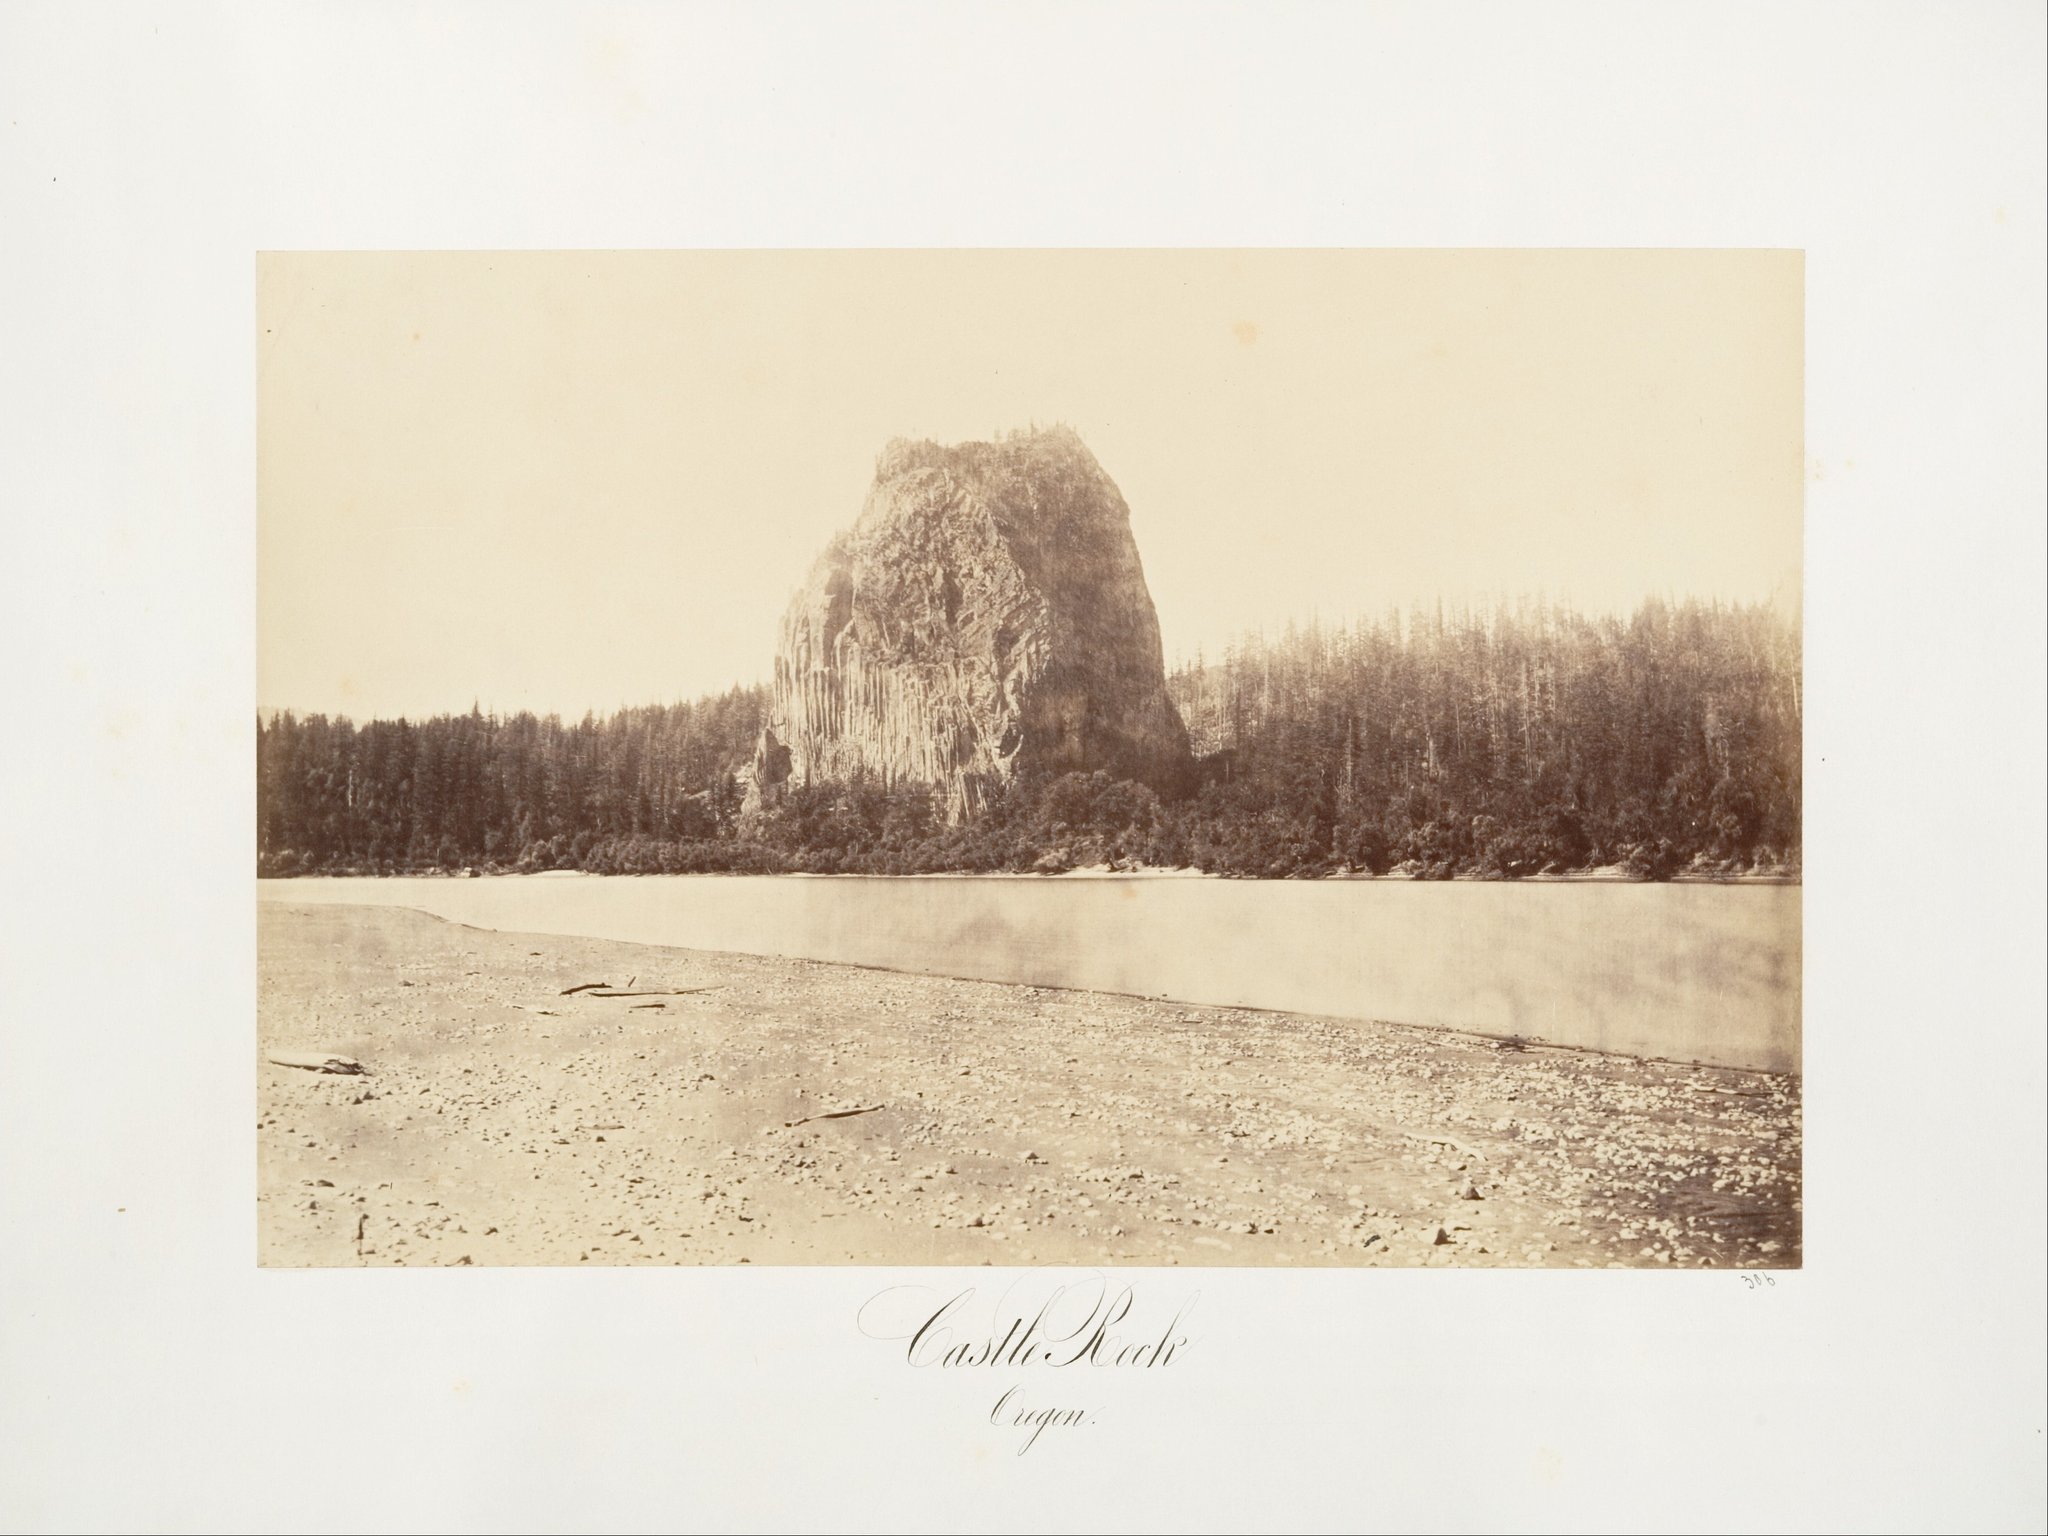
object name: photograph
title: Castle Rock, Oregon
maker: carleton e. watkins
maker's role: artist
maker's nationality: american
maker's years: 1829-1916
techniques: albumen silver print, glass negative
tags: landscapes